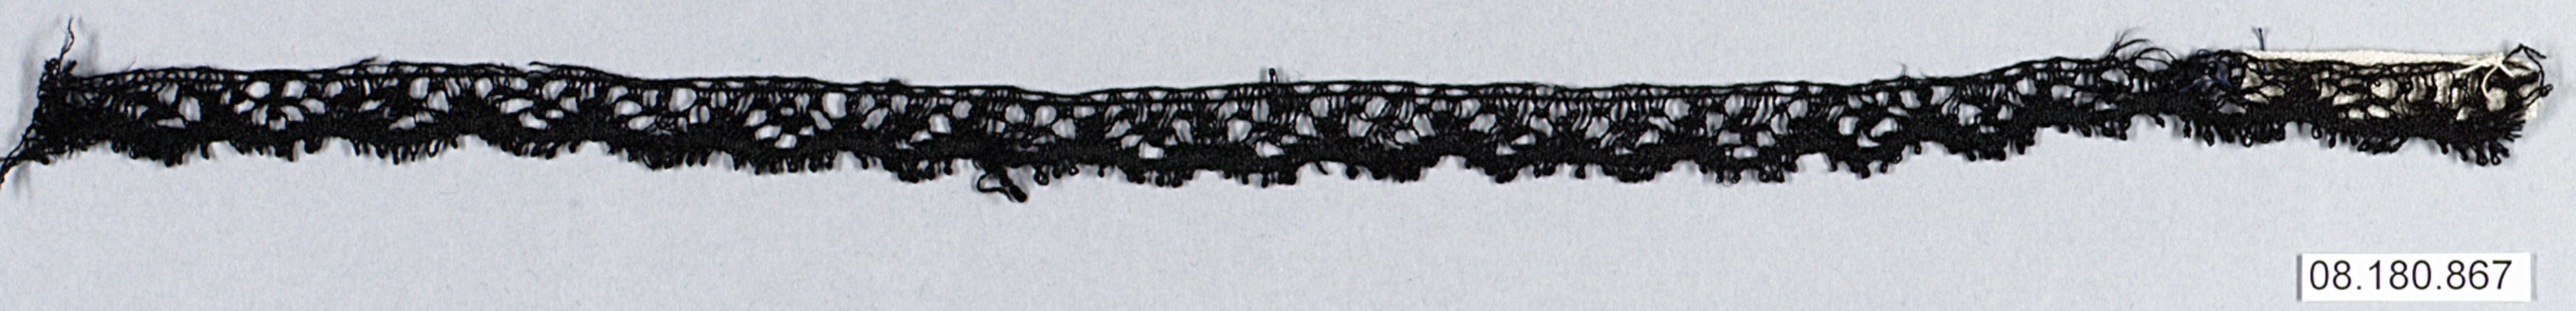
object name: piece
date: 1801-1900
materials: silk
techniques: lace